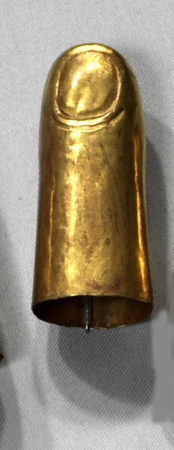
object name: toe stall, group 2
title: Toe stall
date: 1479-1425 BCE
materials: gold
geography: egypt